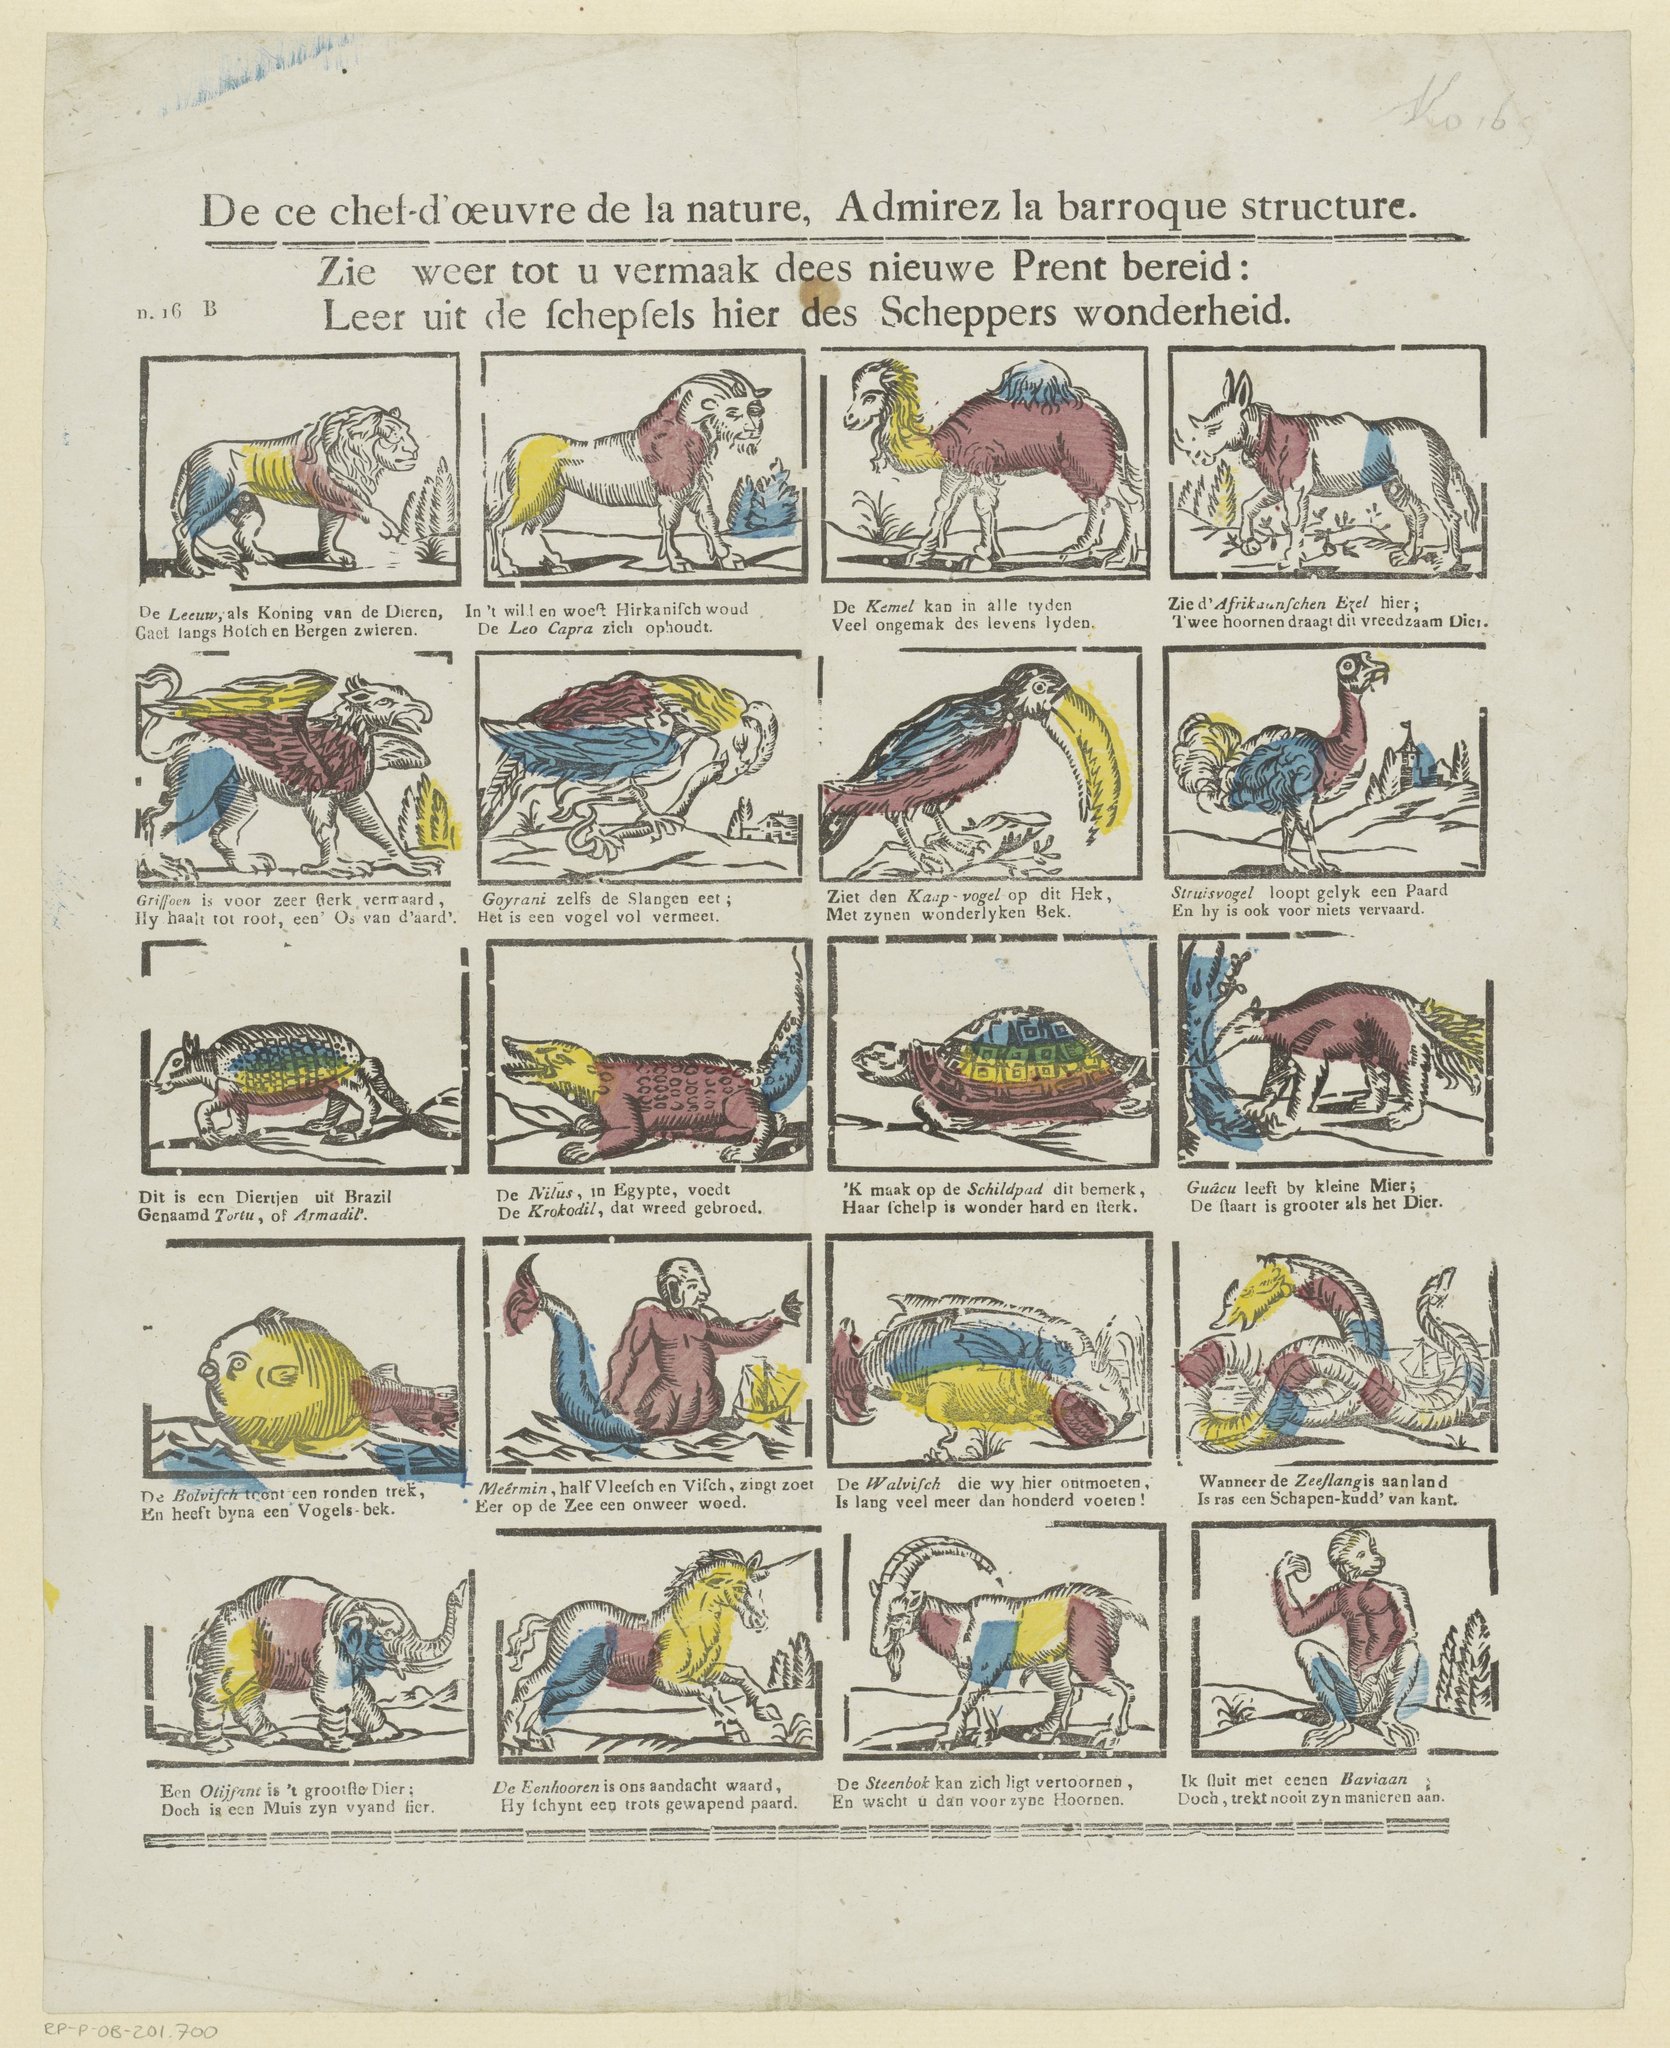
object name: popular print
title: De ce chef d'oeuvre de la nature, Admirez la barroque structure / Zie weer tot u vermaak dees nieuwe prent bereid: / Leer uit de schepsels hier des scheppers wonderheid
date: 1800-1833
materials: paper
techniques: colour, letterpress printing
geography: turnhout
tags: trunked animals, animals, monkeys, apes, birds, hoofed animals, beasts of prey, predatory animals: lion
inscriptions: collector's mark: Lugt 2760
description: Blad met 20 voorstellingen van verschillende dieren, waaronder een leeuw, een struisvogel, een krokodil, een schildpad en een baviaan. Onder elke afbeelding een tweeregelig vers. Genummerd linksboven: n. 16 B.